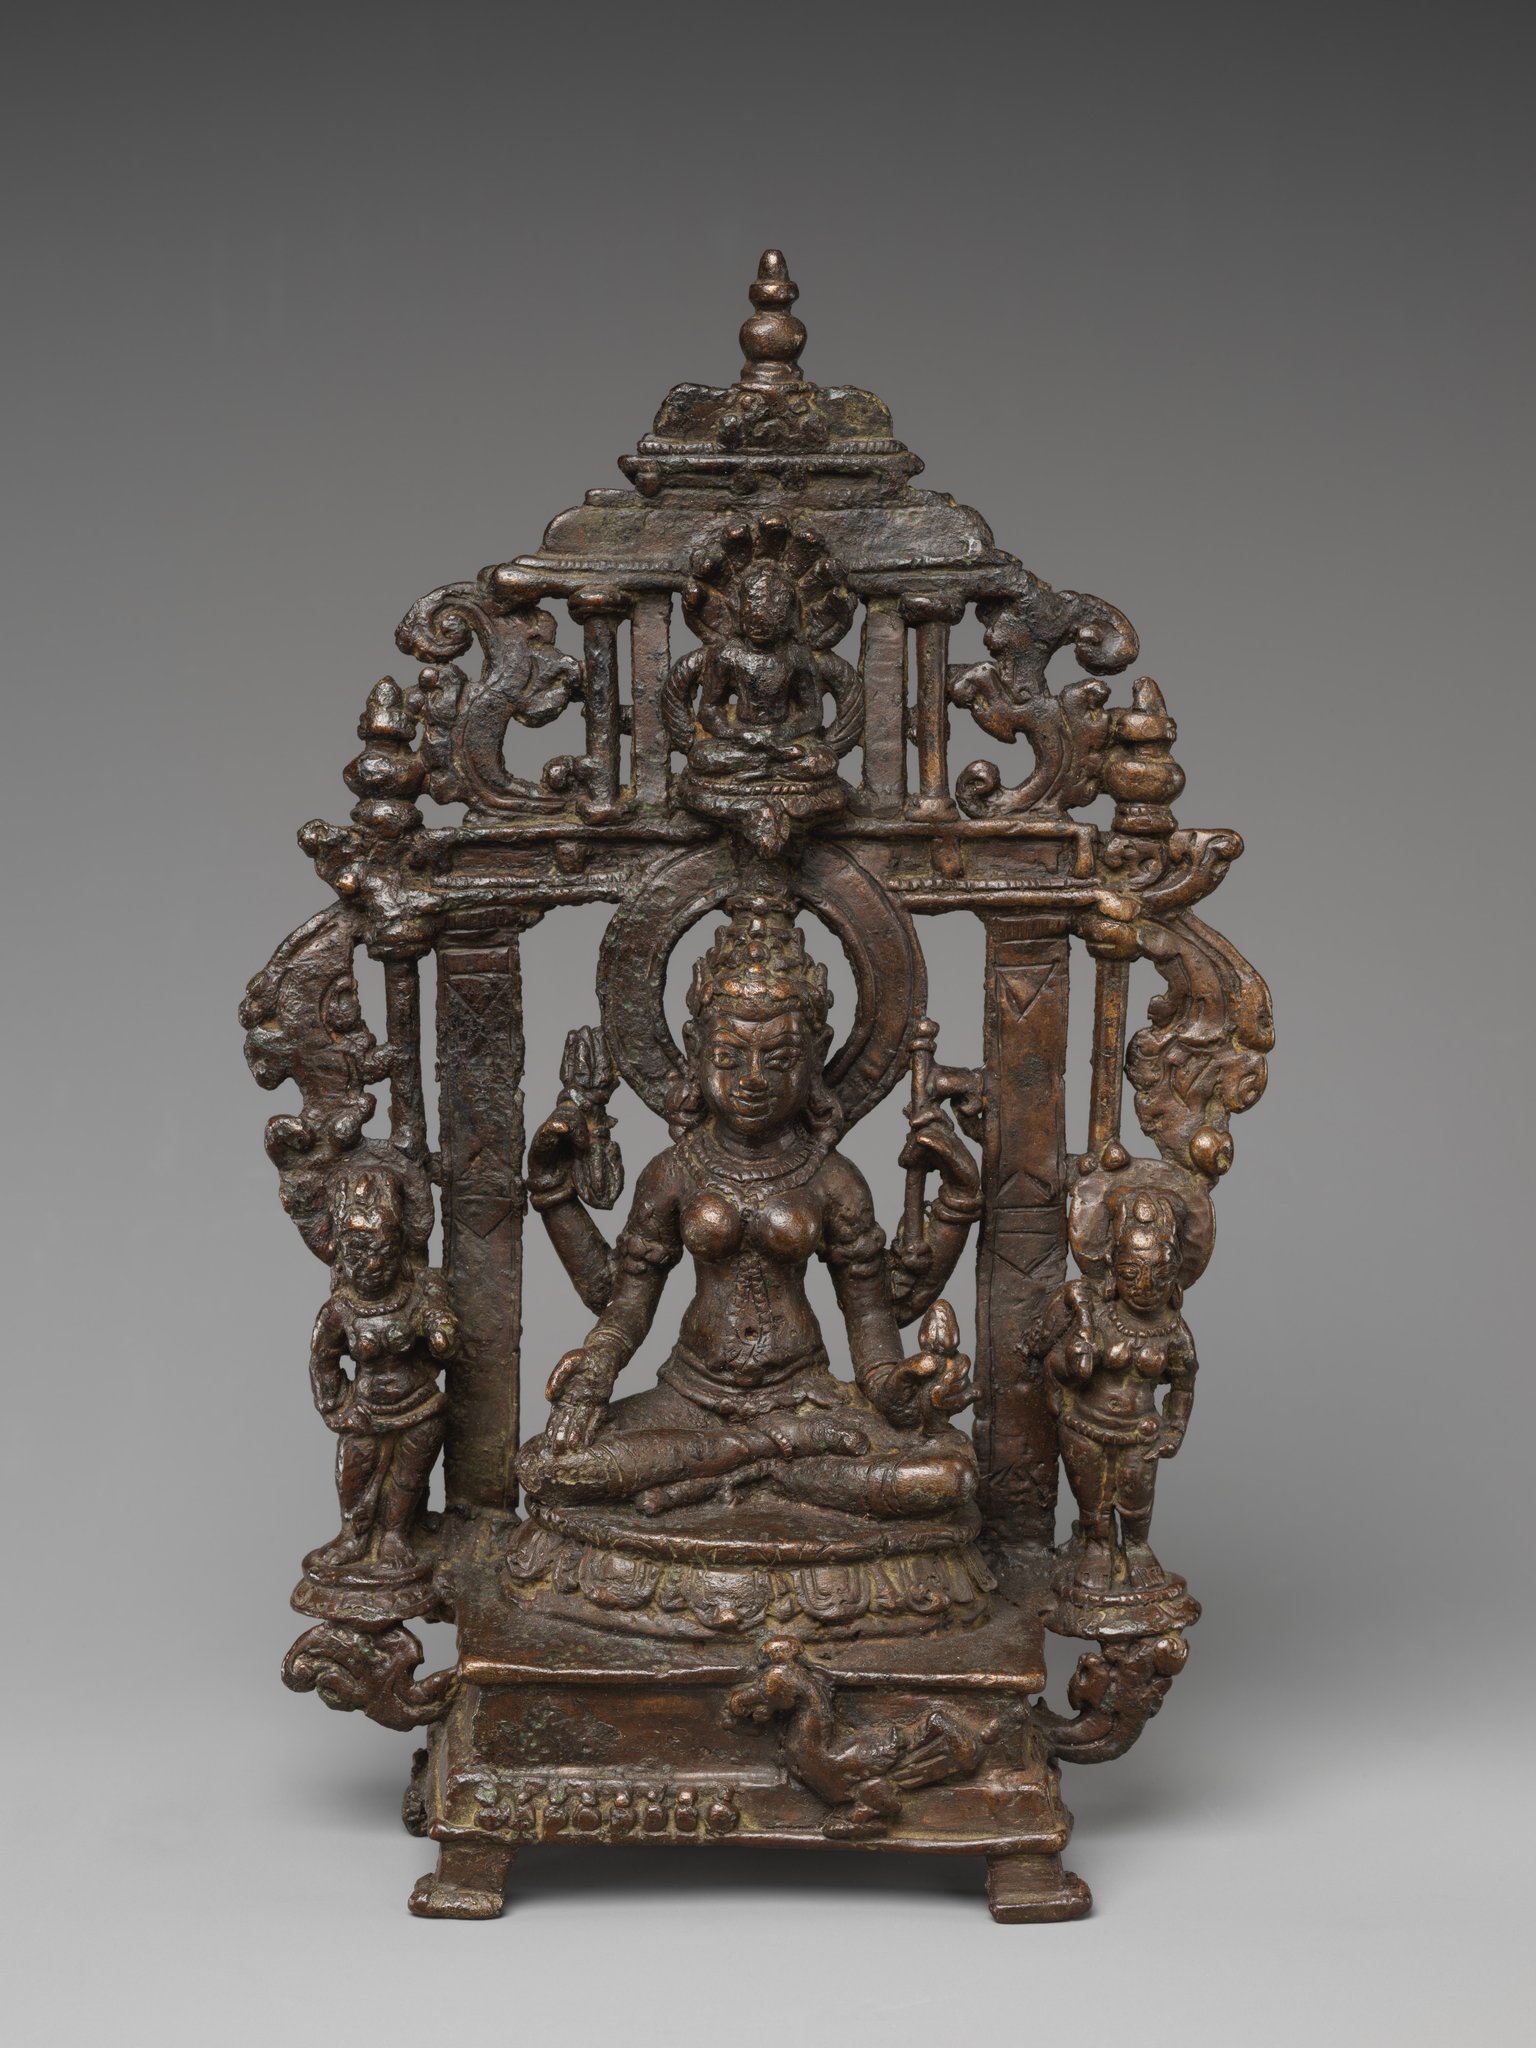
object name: figure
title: Jain Goddess Padmavati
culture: indian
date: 901-1000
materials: copper alloy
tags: goddess